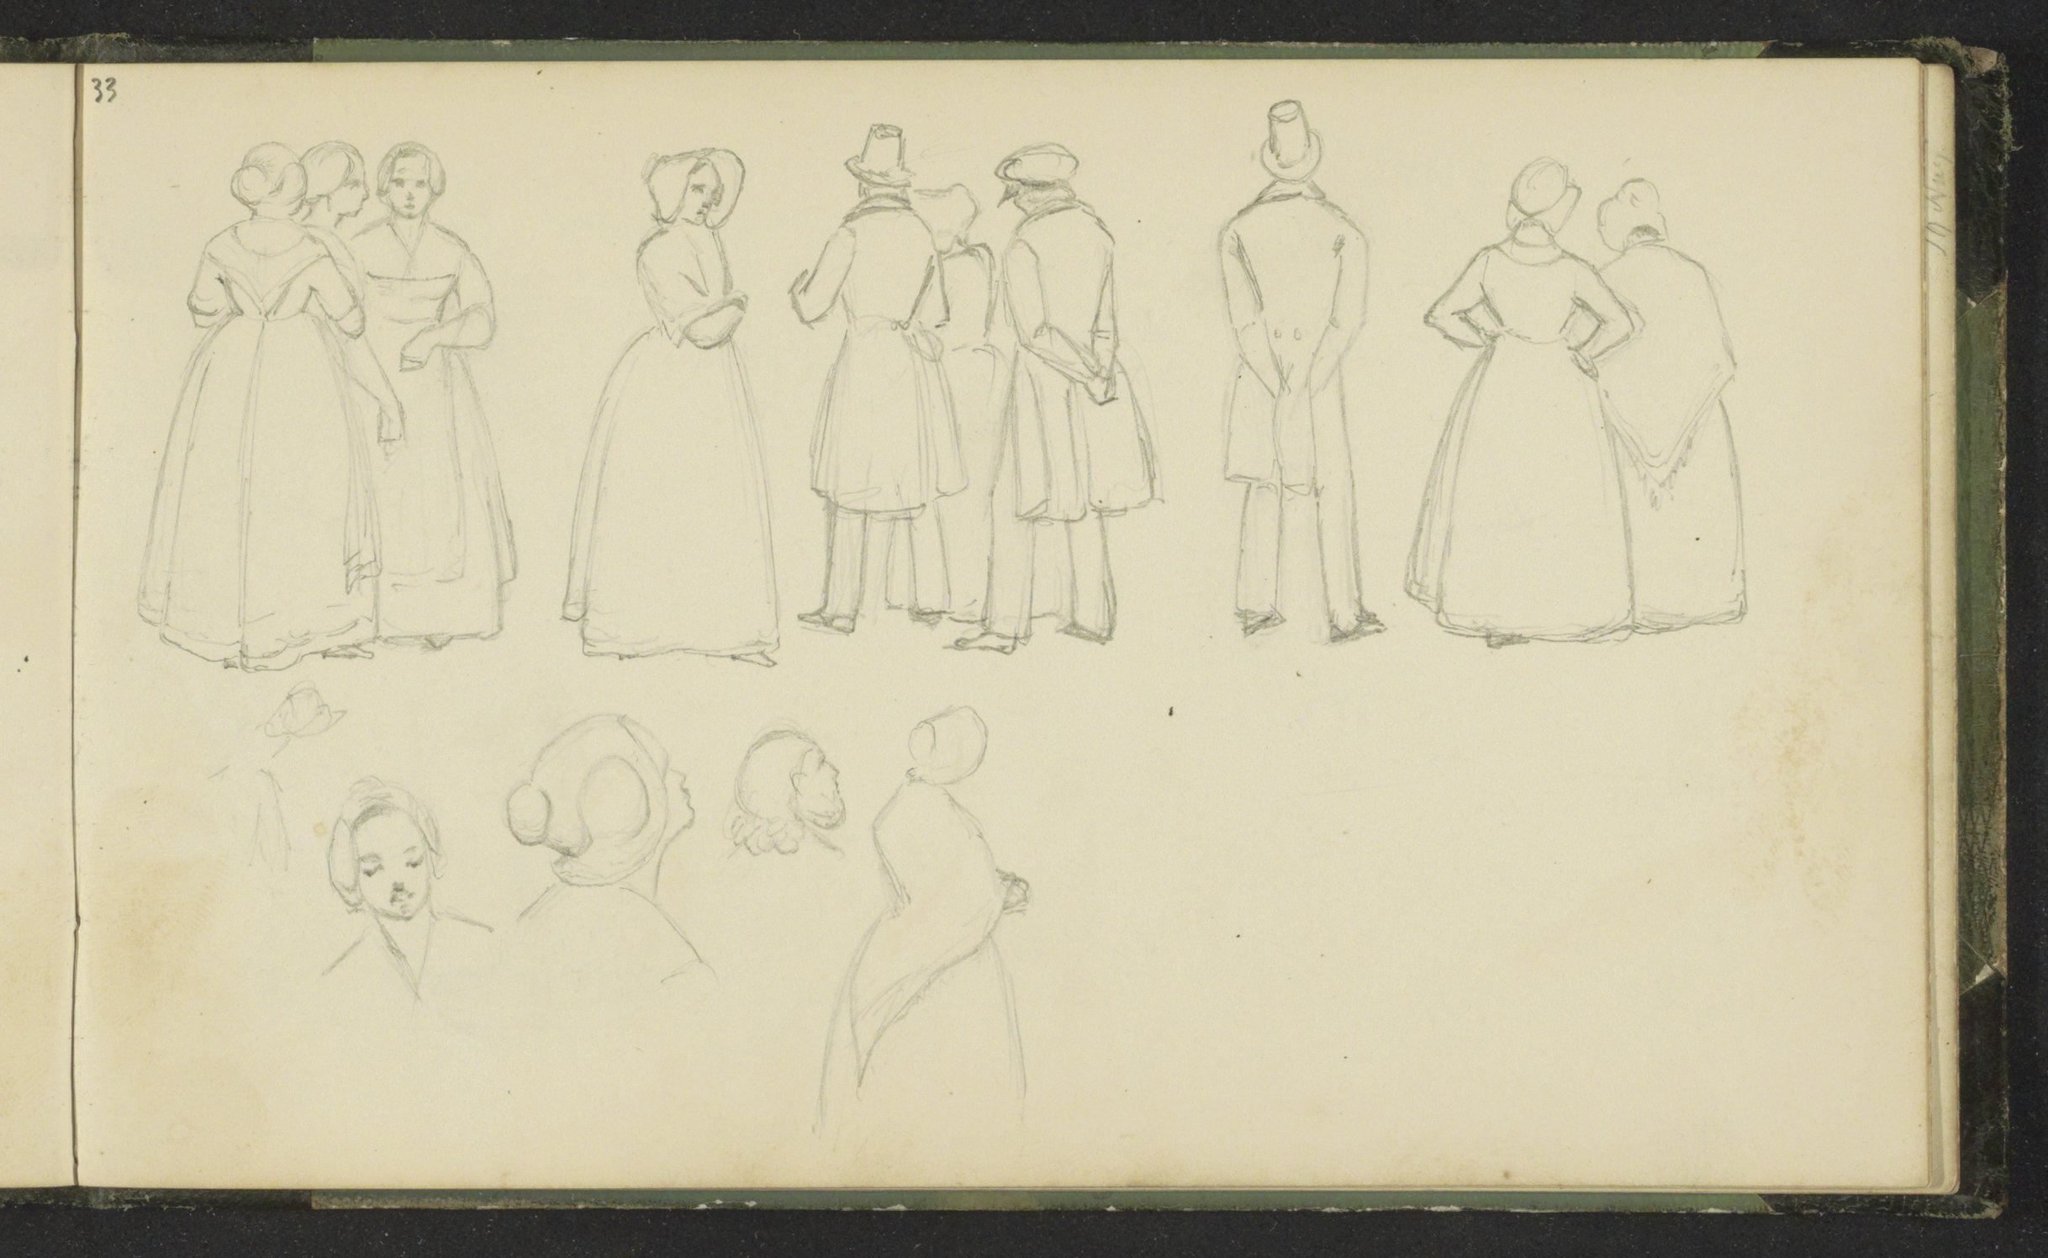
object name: sketchbook leaf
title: Studieblad met staande mannen en vrouwen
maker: hendrik abraham klinkhamer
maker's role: draughtsman, painter, print maker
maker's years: 1810-1872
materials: paper, pencil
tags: standing figure, head-gear: hat (+ men's clothes), standing figure - aa - female human figure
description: De vrouwen dragen kappen en de mannen hoge hoed of petten. Blad 33 recto uit een schetsboek met 40 bladen.